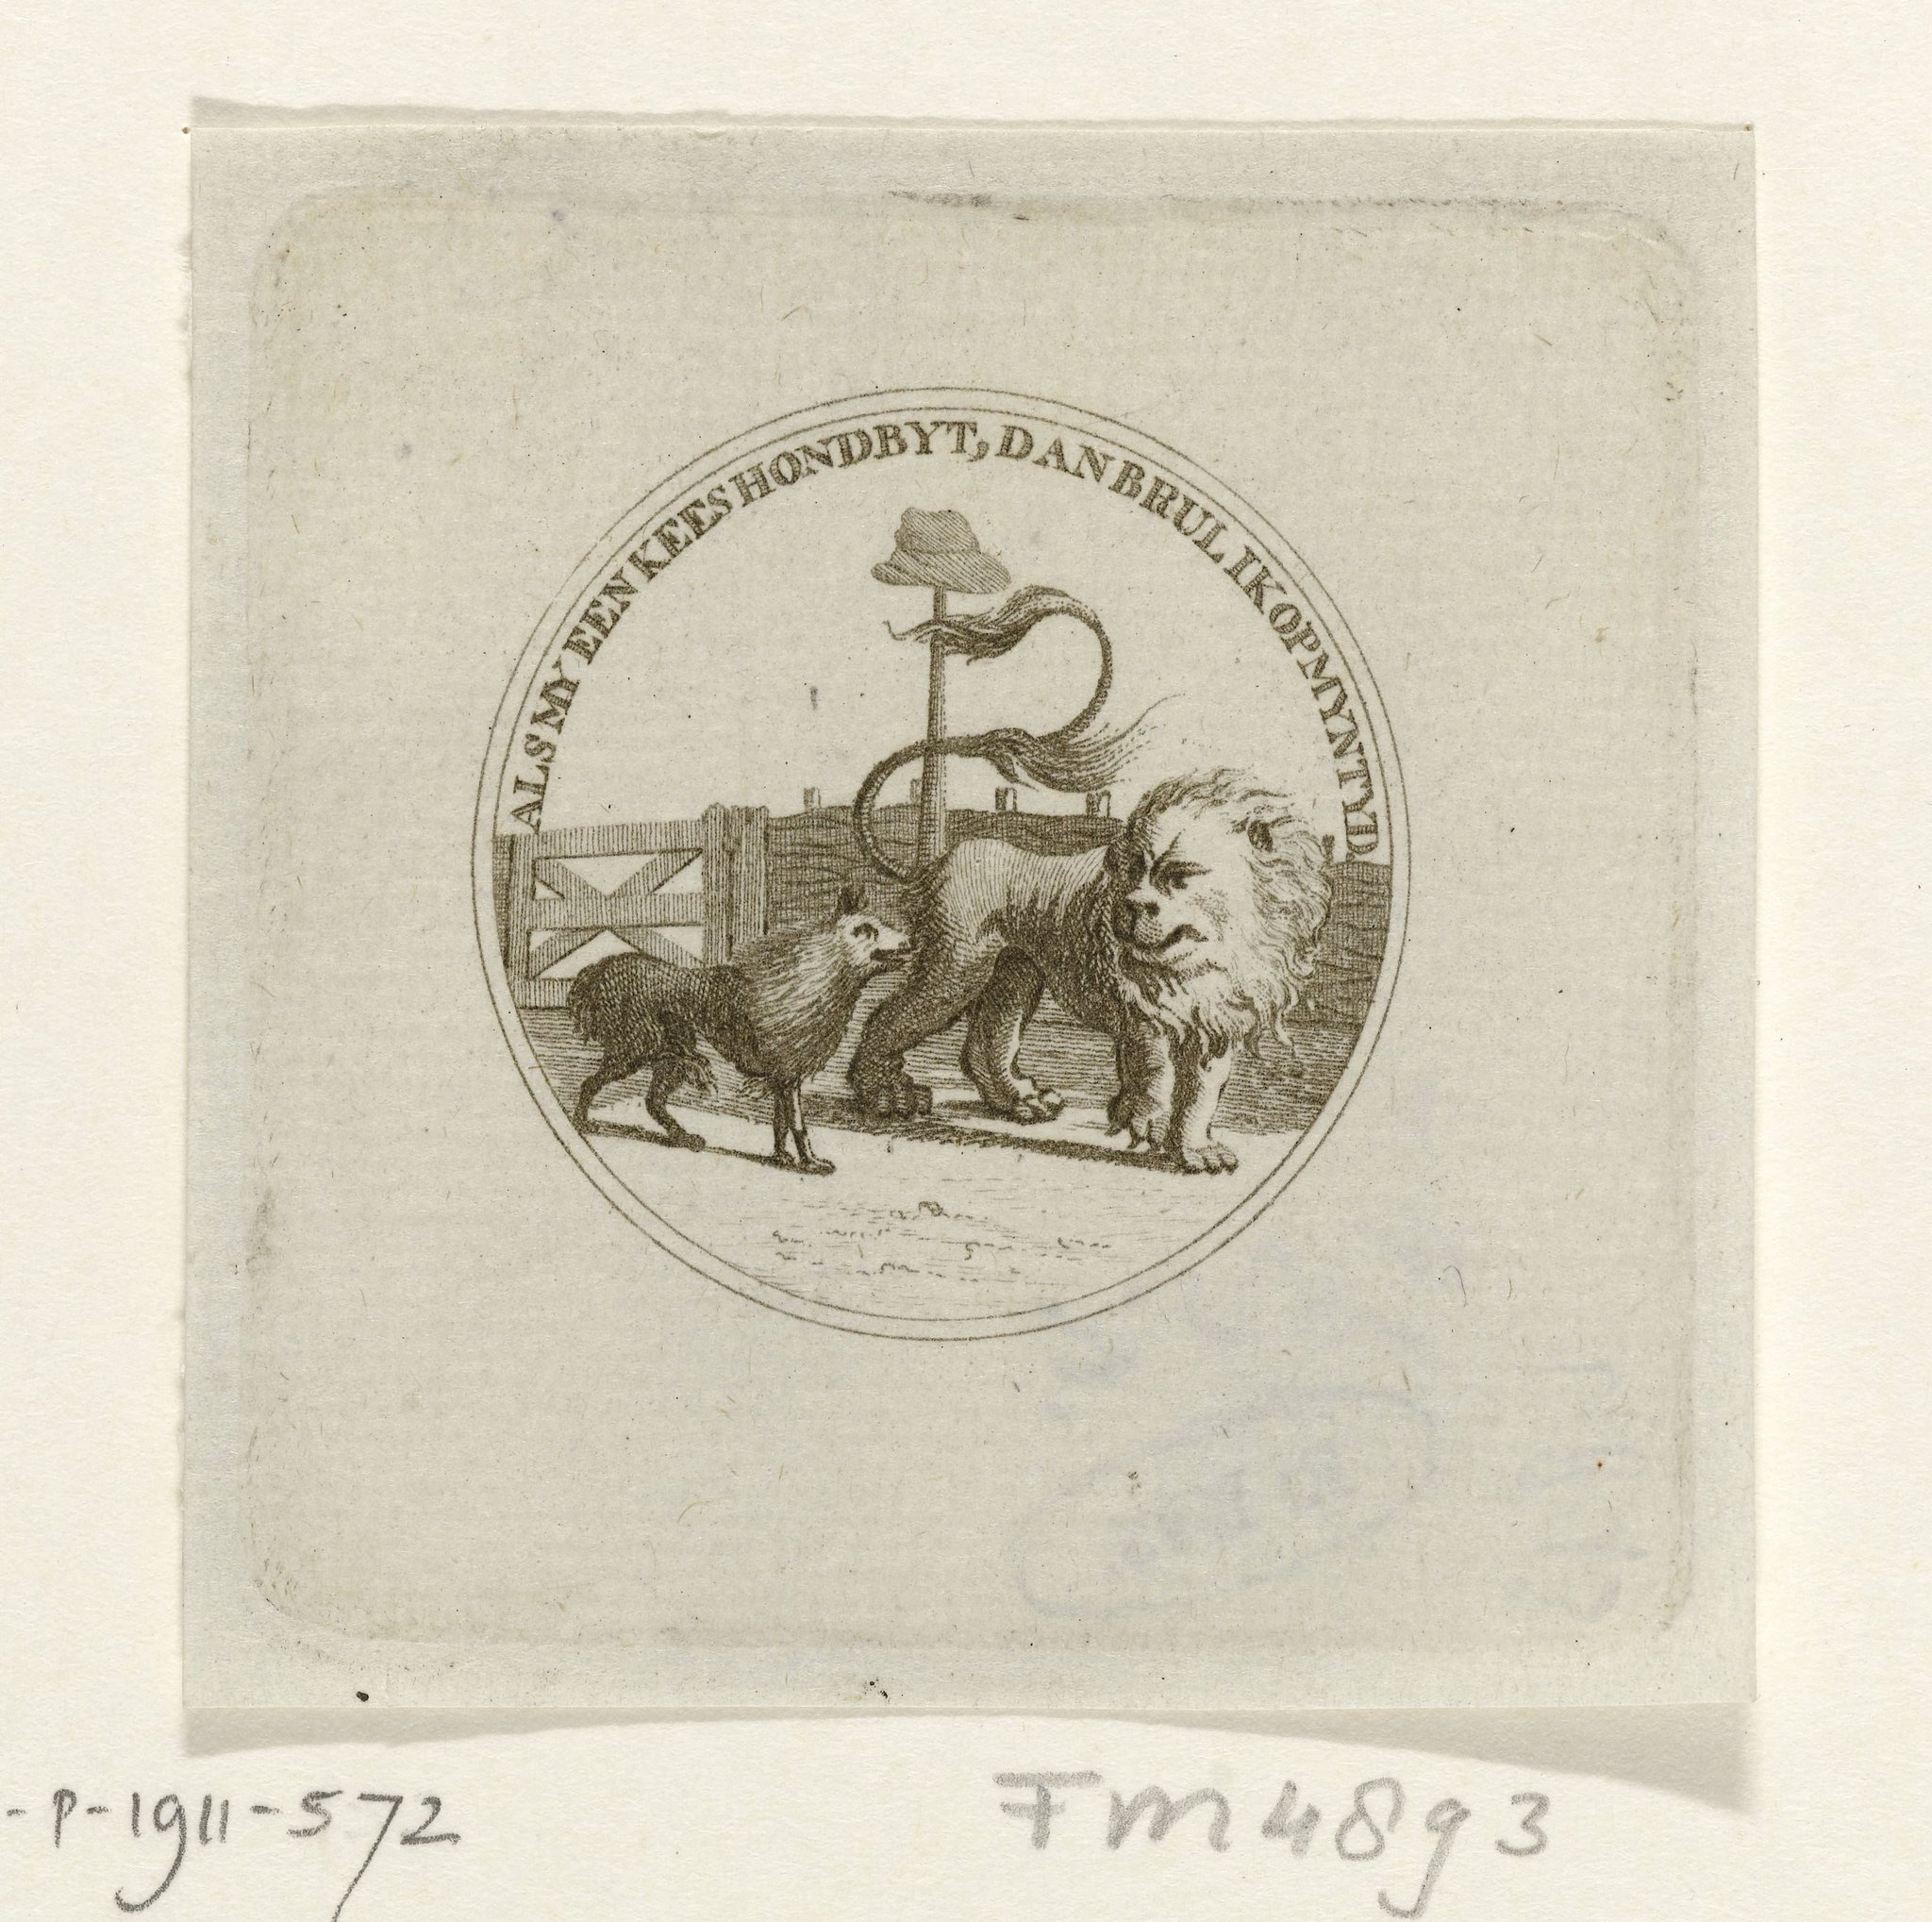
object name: print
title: Medaillon met keeshond en leeuw, ca. 1787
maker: Anonymous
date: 1787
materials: paper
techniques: etching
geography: northern netherlands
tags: fenced or walled garden; 'hortus conclusus', beasts of prey, predatory animals: lion, dog, patriots (1780-1795)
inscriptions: collector's mark: Lugt 2228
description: Medaillon met een keeshond en de Nederlandse Leeuw in de Hollandse Tuin, ca. 1787. De leeuw zegt "Als my een keeshond byt, dan brul ik op myn tyd".